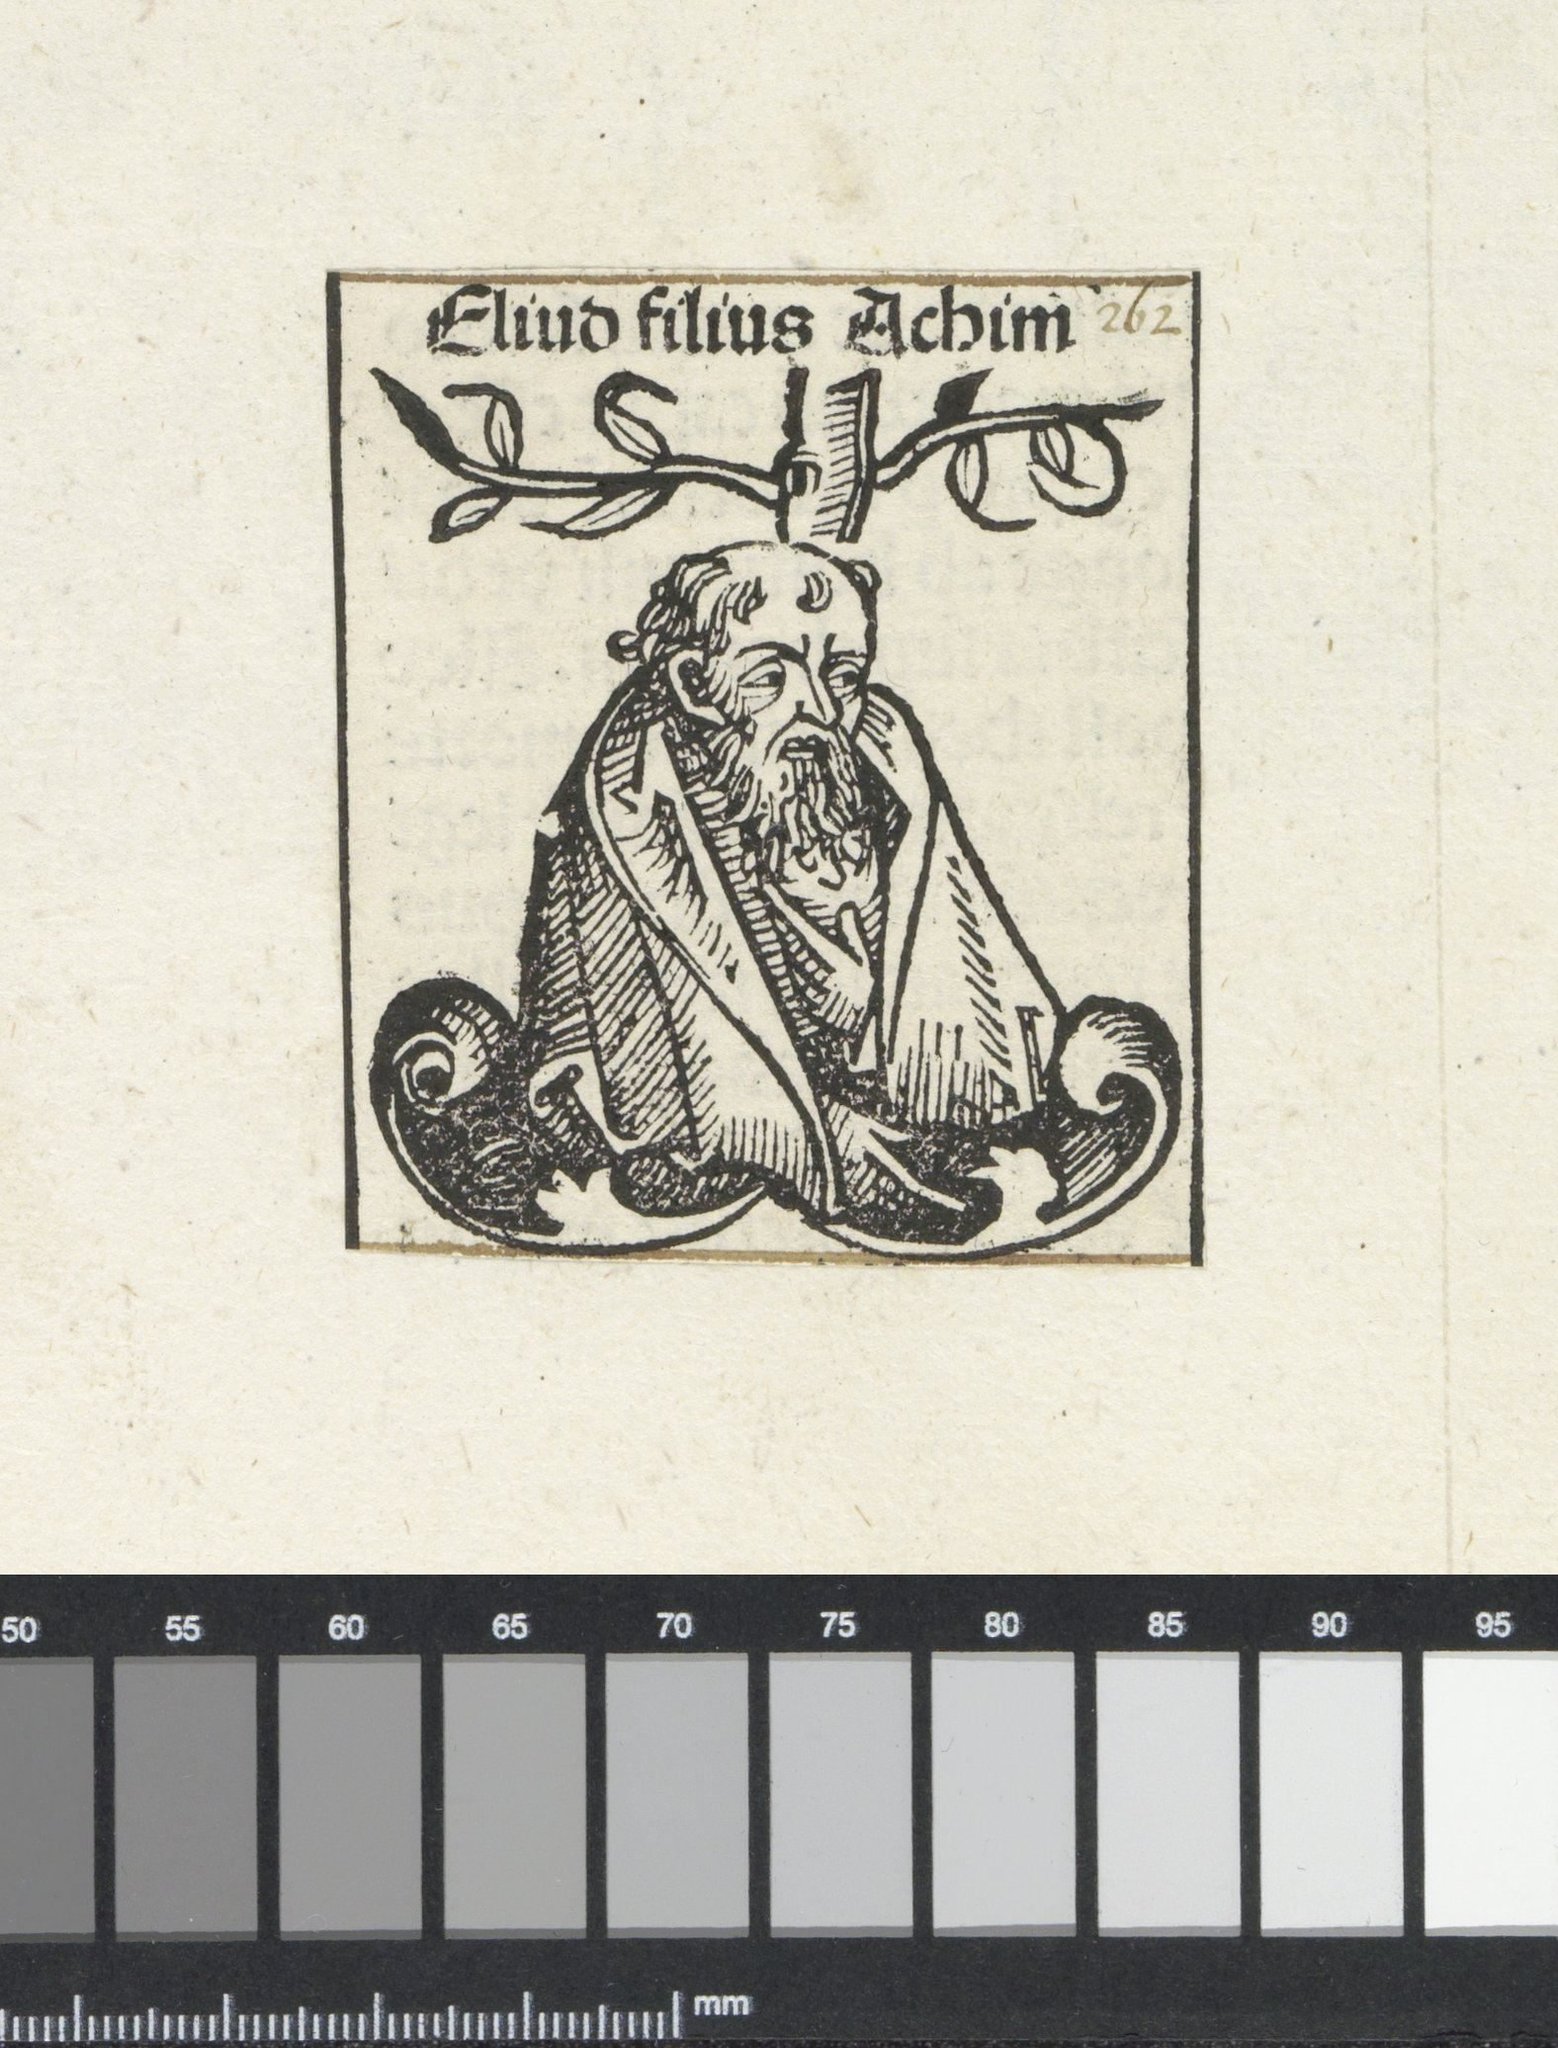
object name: print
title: Elius filius Achim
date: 1493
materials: paper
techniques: letterpress printing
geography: nuremberg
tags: persons from the old testament (not in biblical context, nor occurring in legendary/historical extensions included in division 71)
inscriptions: inscription: ‘262’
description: Een bloemkelk waarin een bebaarde man met een mantel, naar rechts gedraaid. De tekst identificeert hem als Eliud, zoon van Achim (Mat. 1:14). De voorstelling is onderdeel van de stamboom van Christus in de Liber Chronicarum. De prent maakt deel uit van een album.